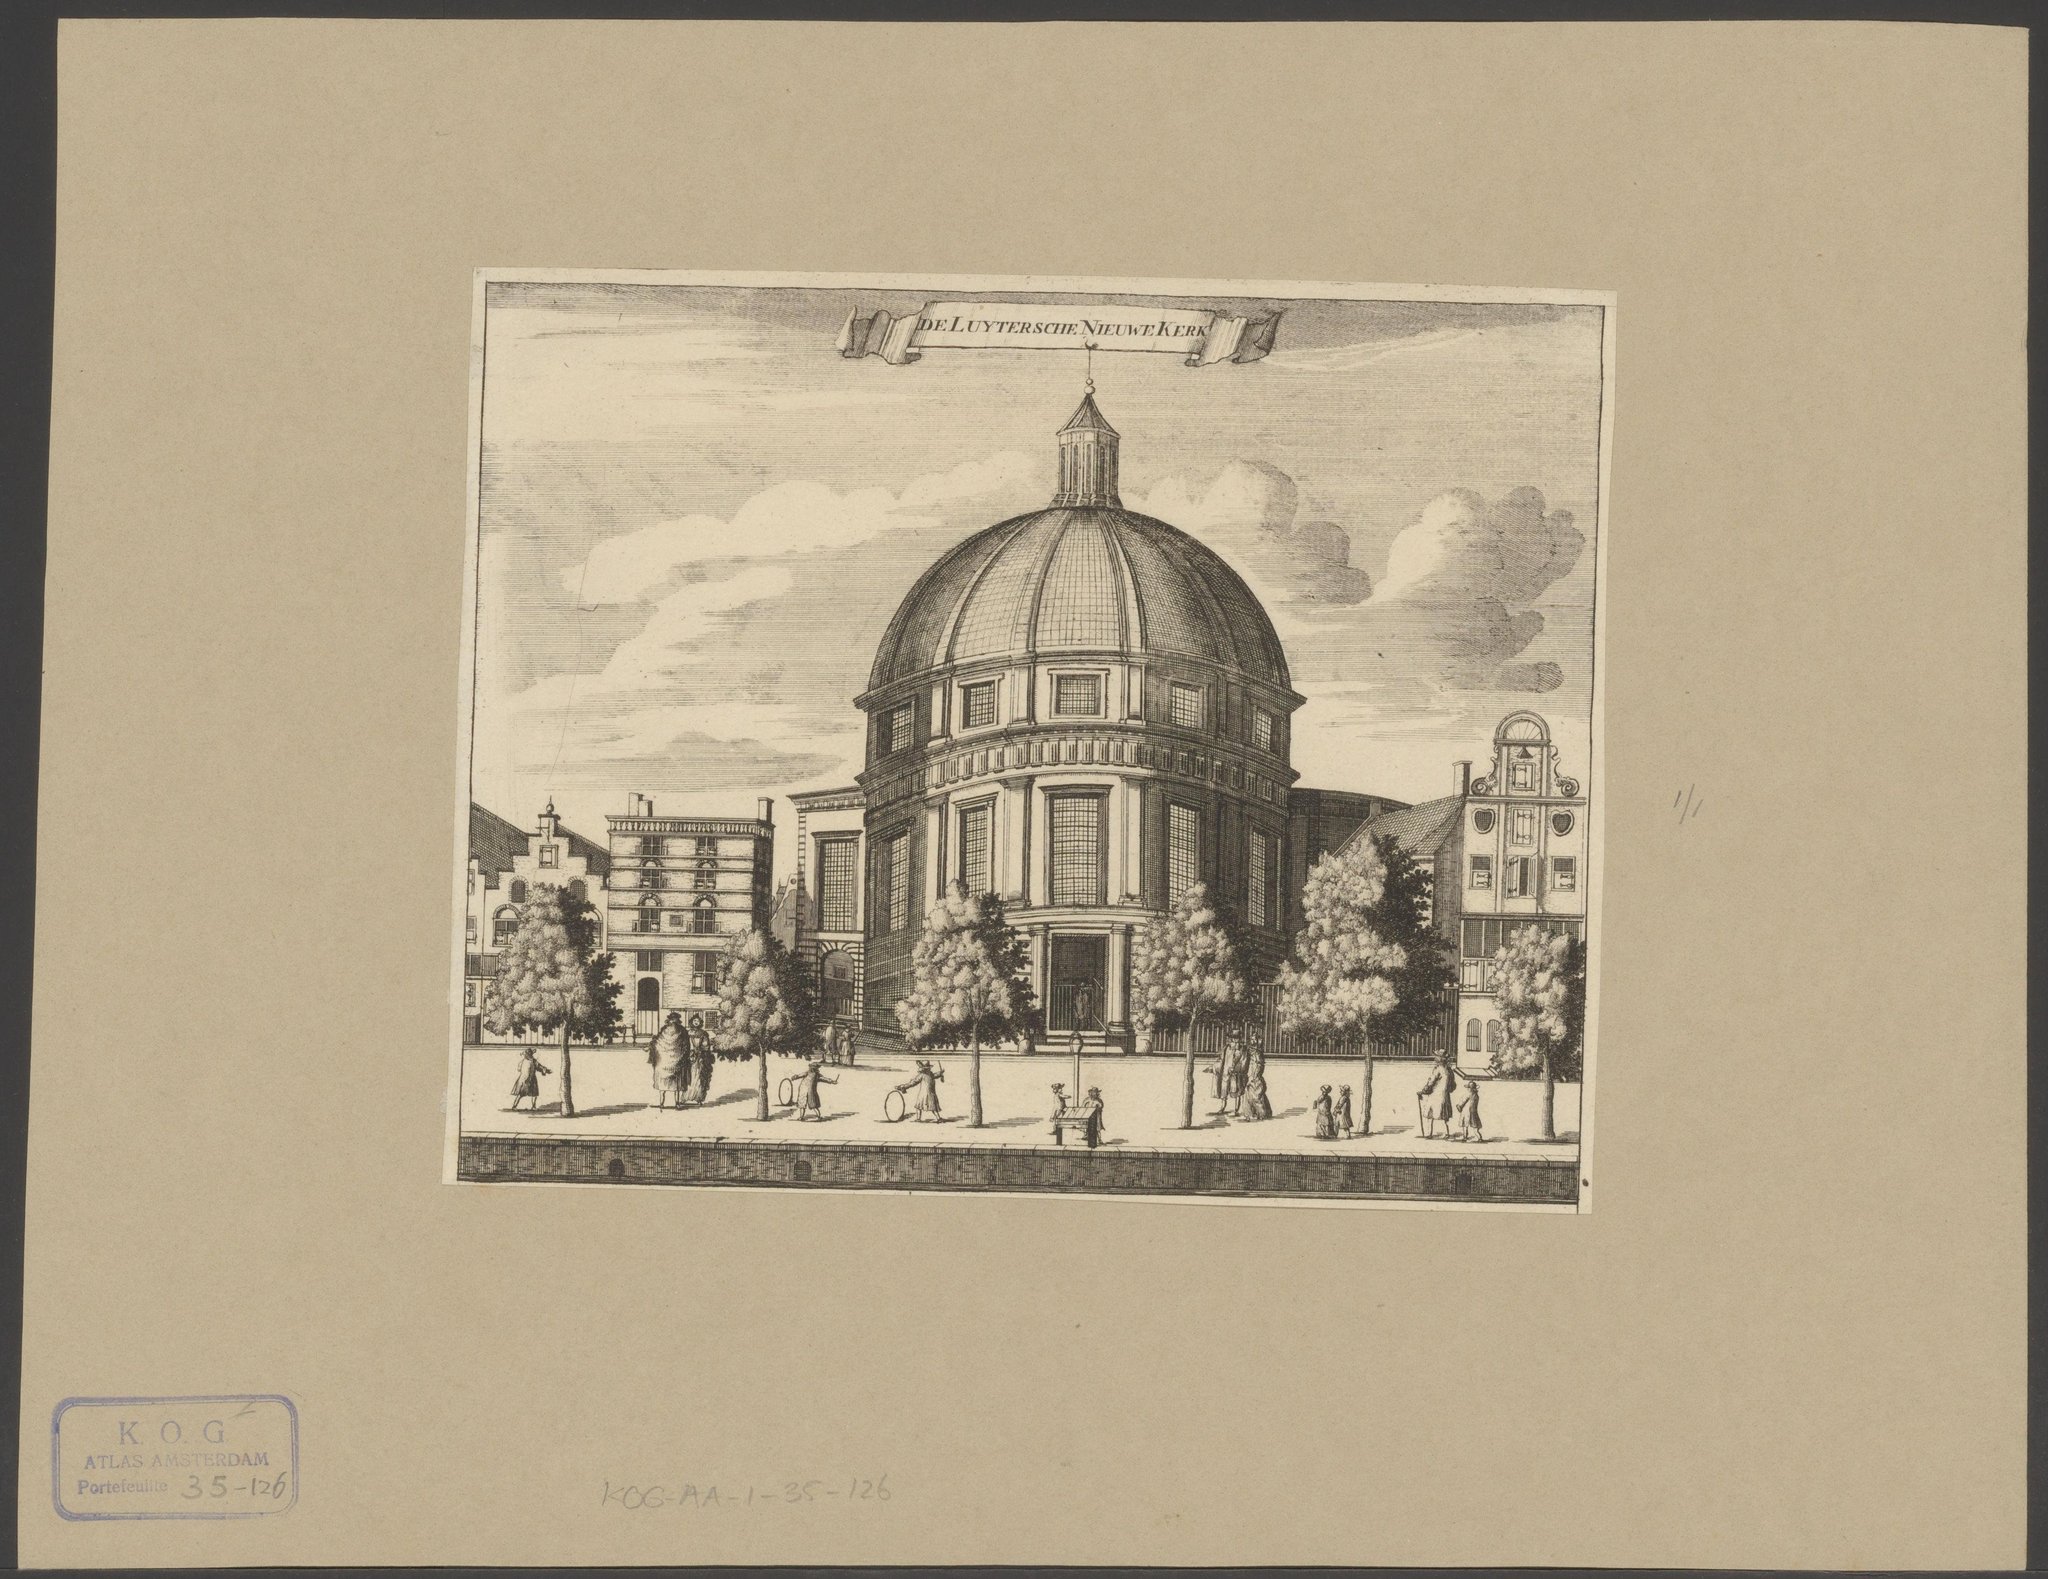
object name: print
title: Gezicht op de koepelkerk of Nieuwe Lutherse Kerk te Amsterdam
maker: Anonymous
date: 1700-1799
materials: paper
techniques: engraving, etching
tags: protestant churches and denominations (lutherans), parts of church exterior and annexes: dome, canals, waters (in city) (+ city(-scape) with figures, staffage)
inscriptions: collector's mark: ‘35-126’ Lugt 1641b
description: Onderwerpsrubriek binnen de Atlas Amsterdam: Ev. Lutherse Gemeente: Nieuwe of Ronde Kerk.